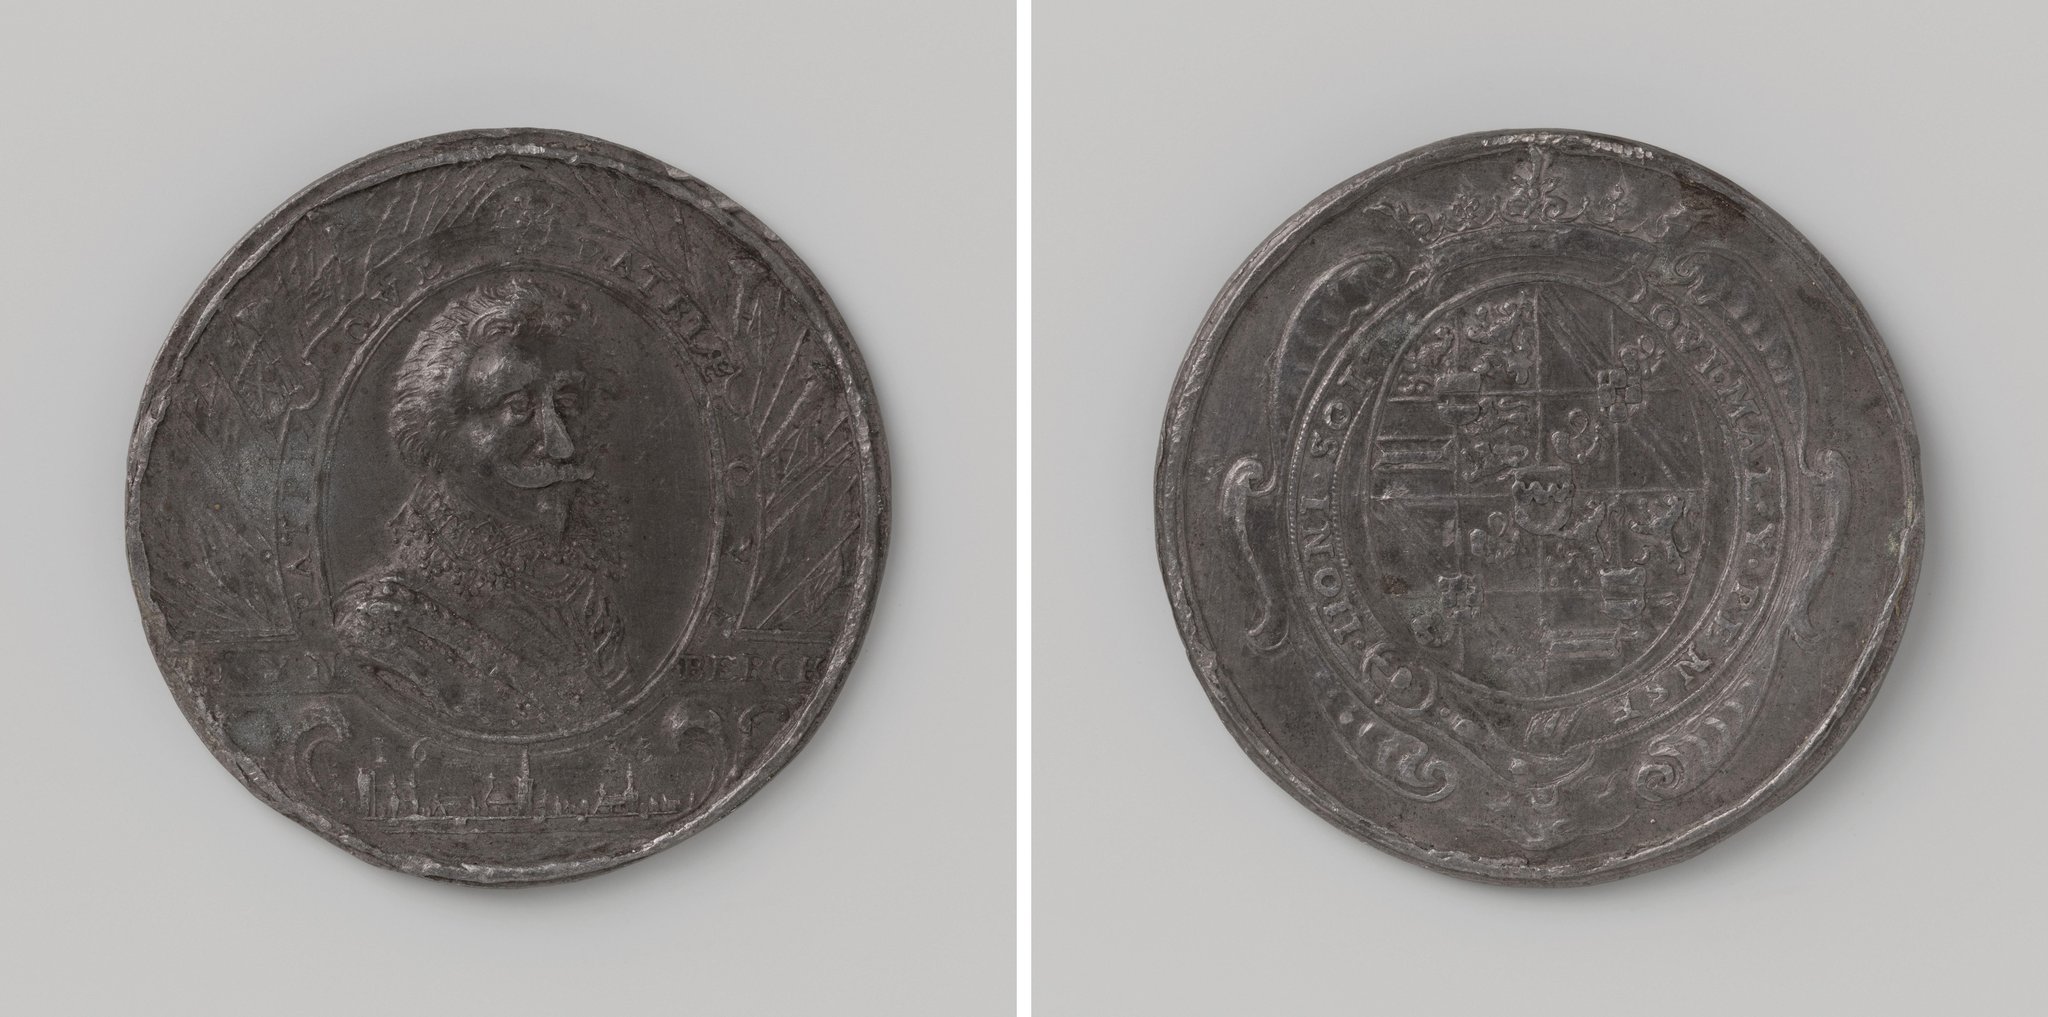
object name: copy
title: Verovering van Rheinberg door Frederik Hendrik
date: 1633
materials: lead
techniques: striking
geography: dordrecht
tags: the hague, frederick henry (prince of orange)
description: Loden penning. Voorzijde: borststuk man binnen omschrift en rand met vaandels en trompetten, daaronder gezicht op stad Rheinberg. Keerzijde: gekroond wapenschild, omhangen met orde van Kouseband